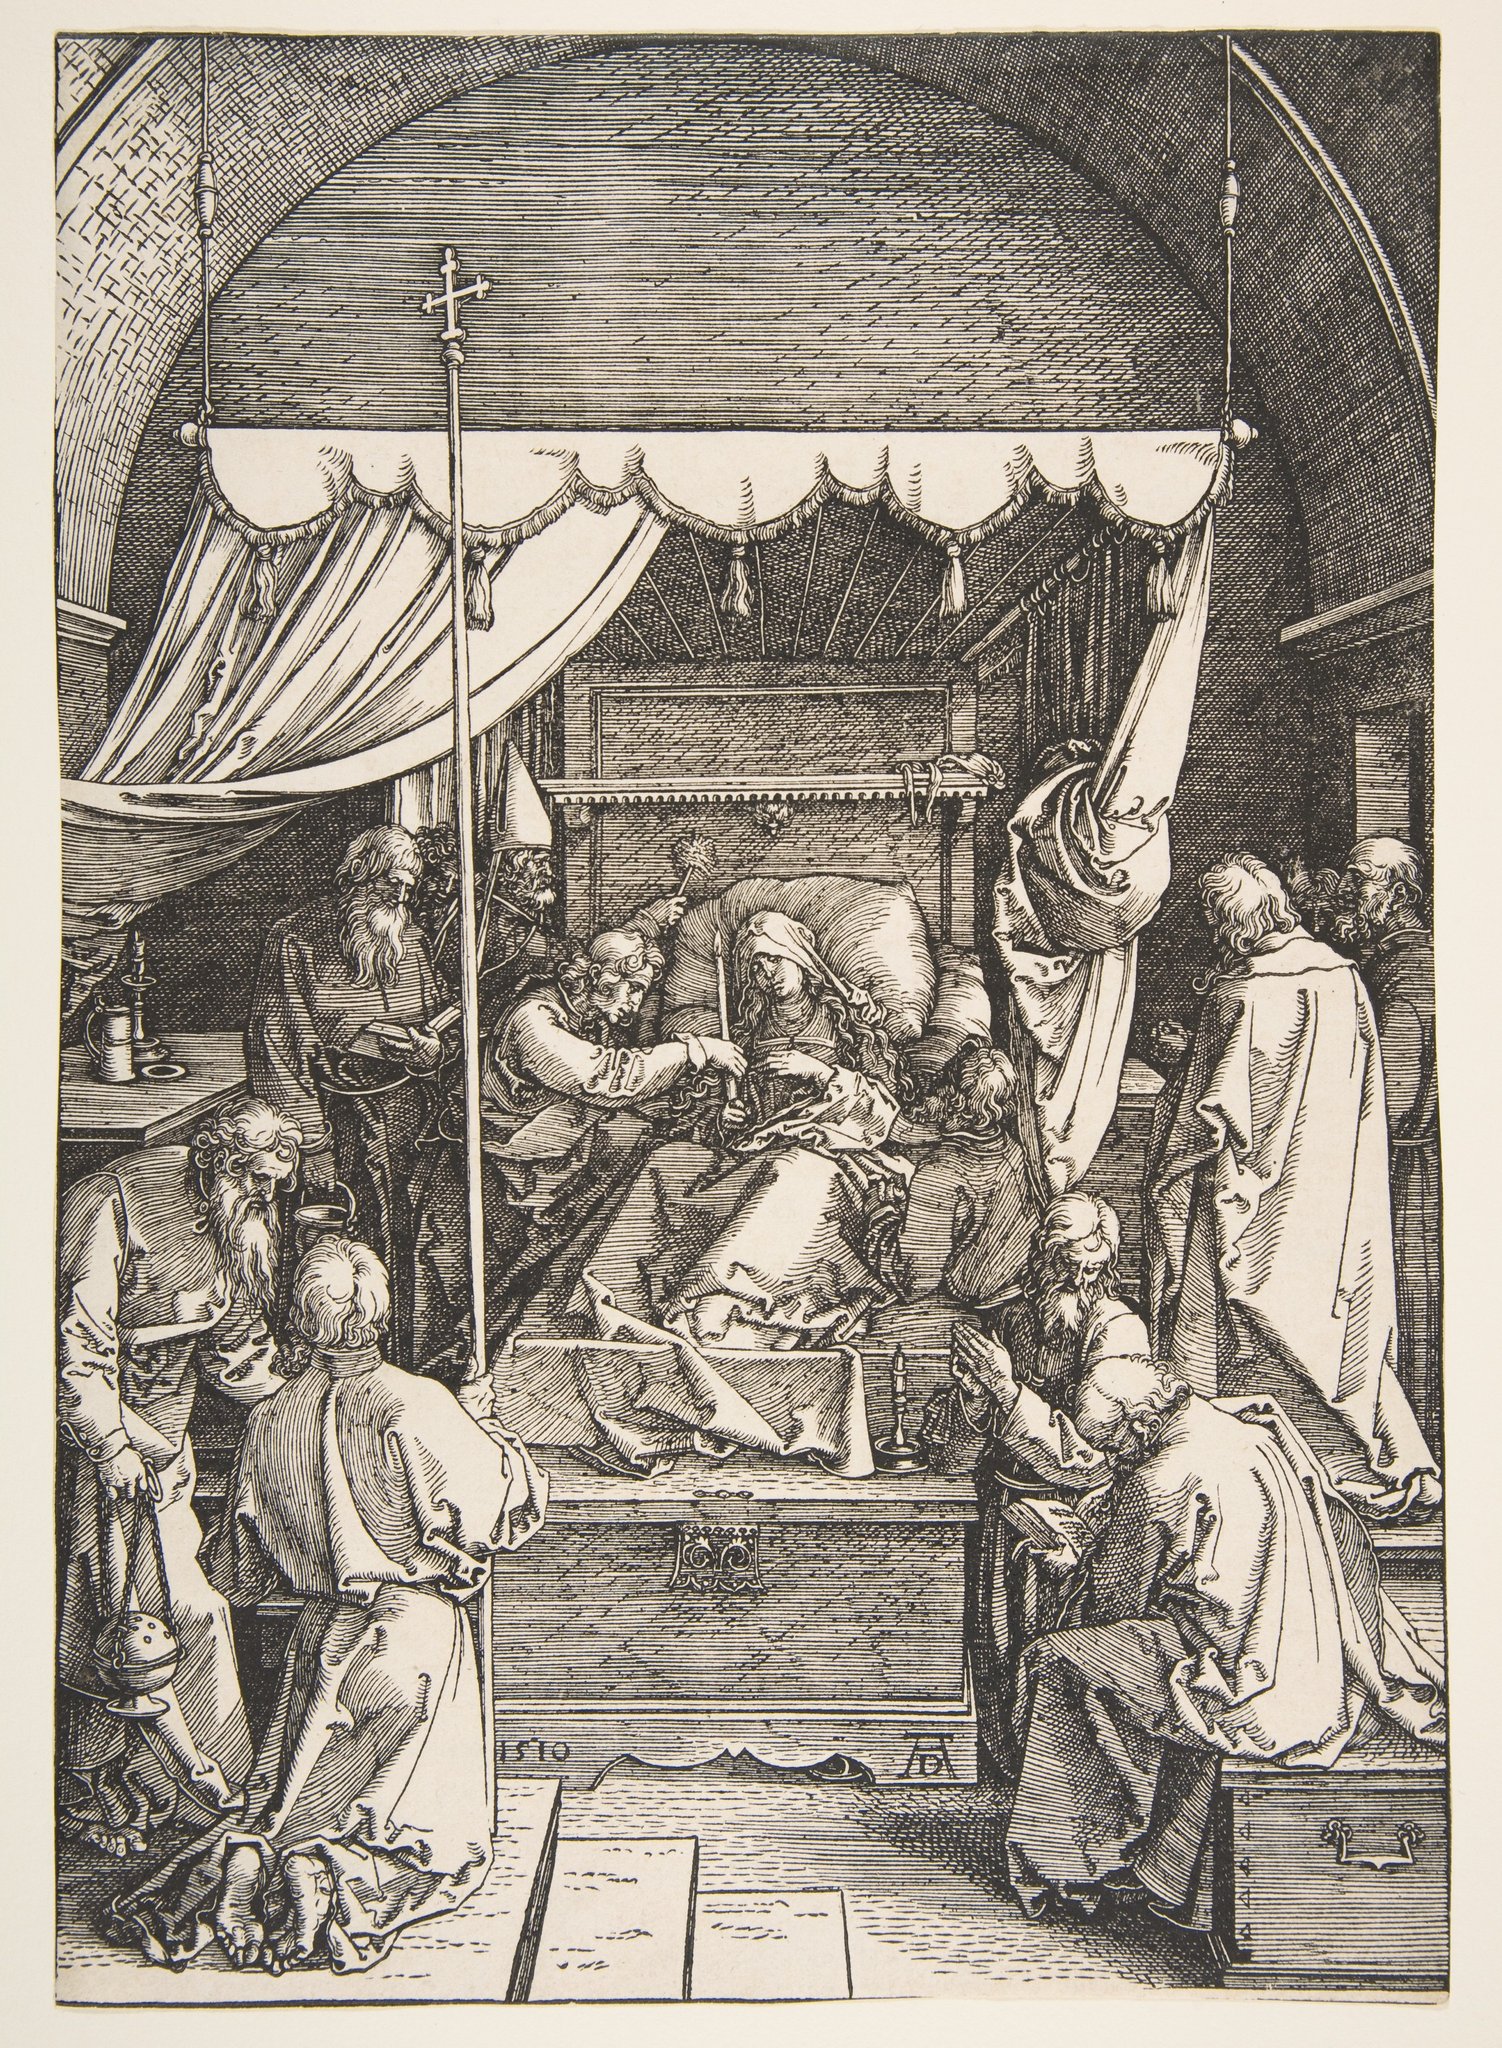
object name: print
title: The Death of the Virgin, from the The Life of the Virgin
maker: albrecht dürer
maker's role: artist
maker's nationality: german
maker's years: 1471-1528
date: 1510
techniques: woodcut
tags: bedrooms,sadness,men,virgin mary,death